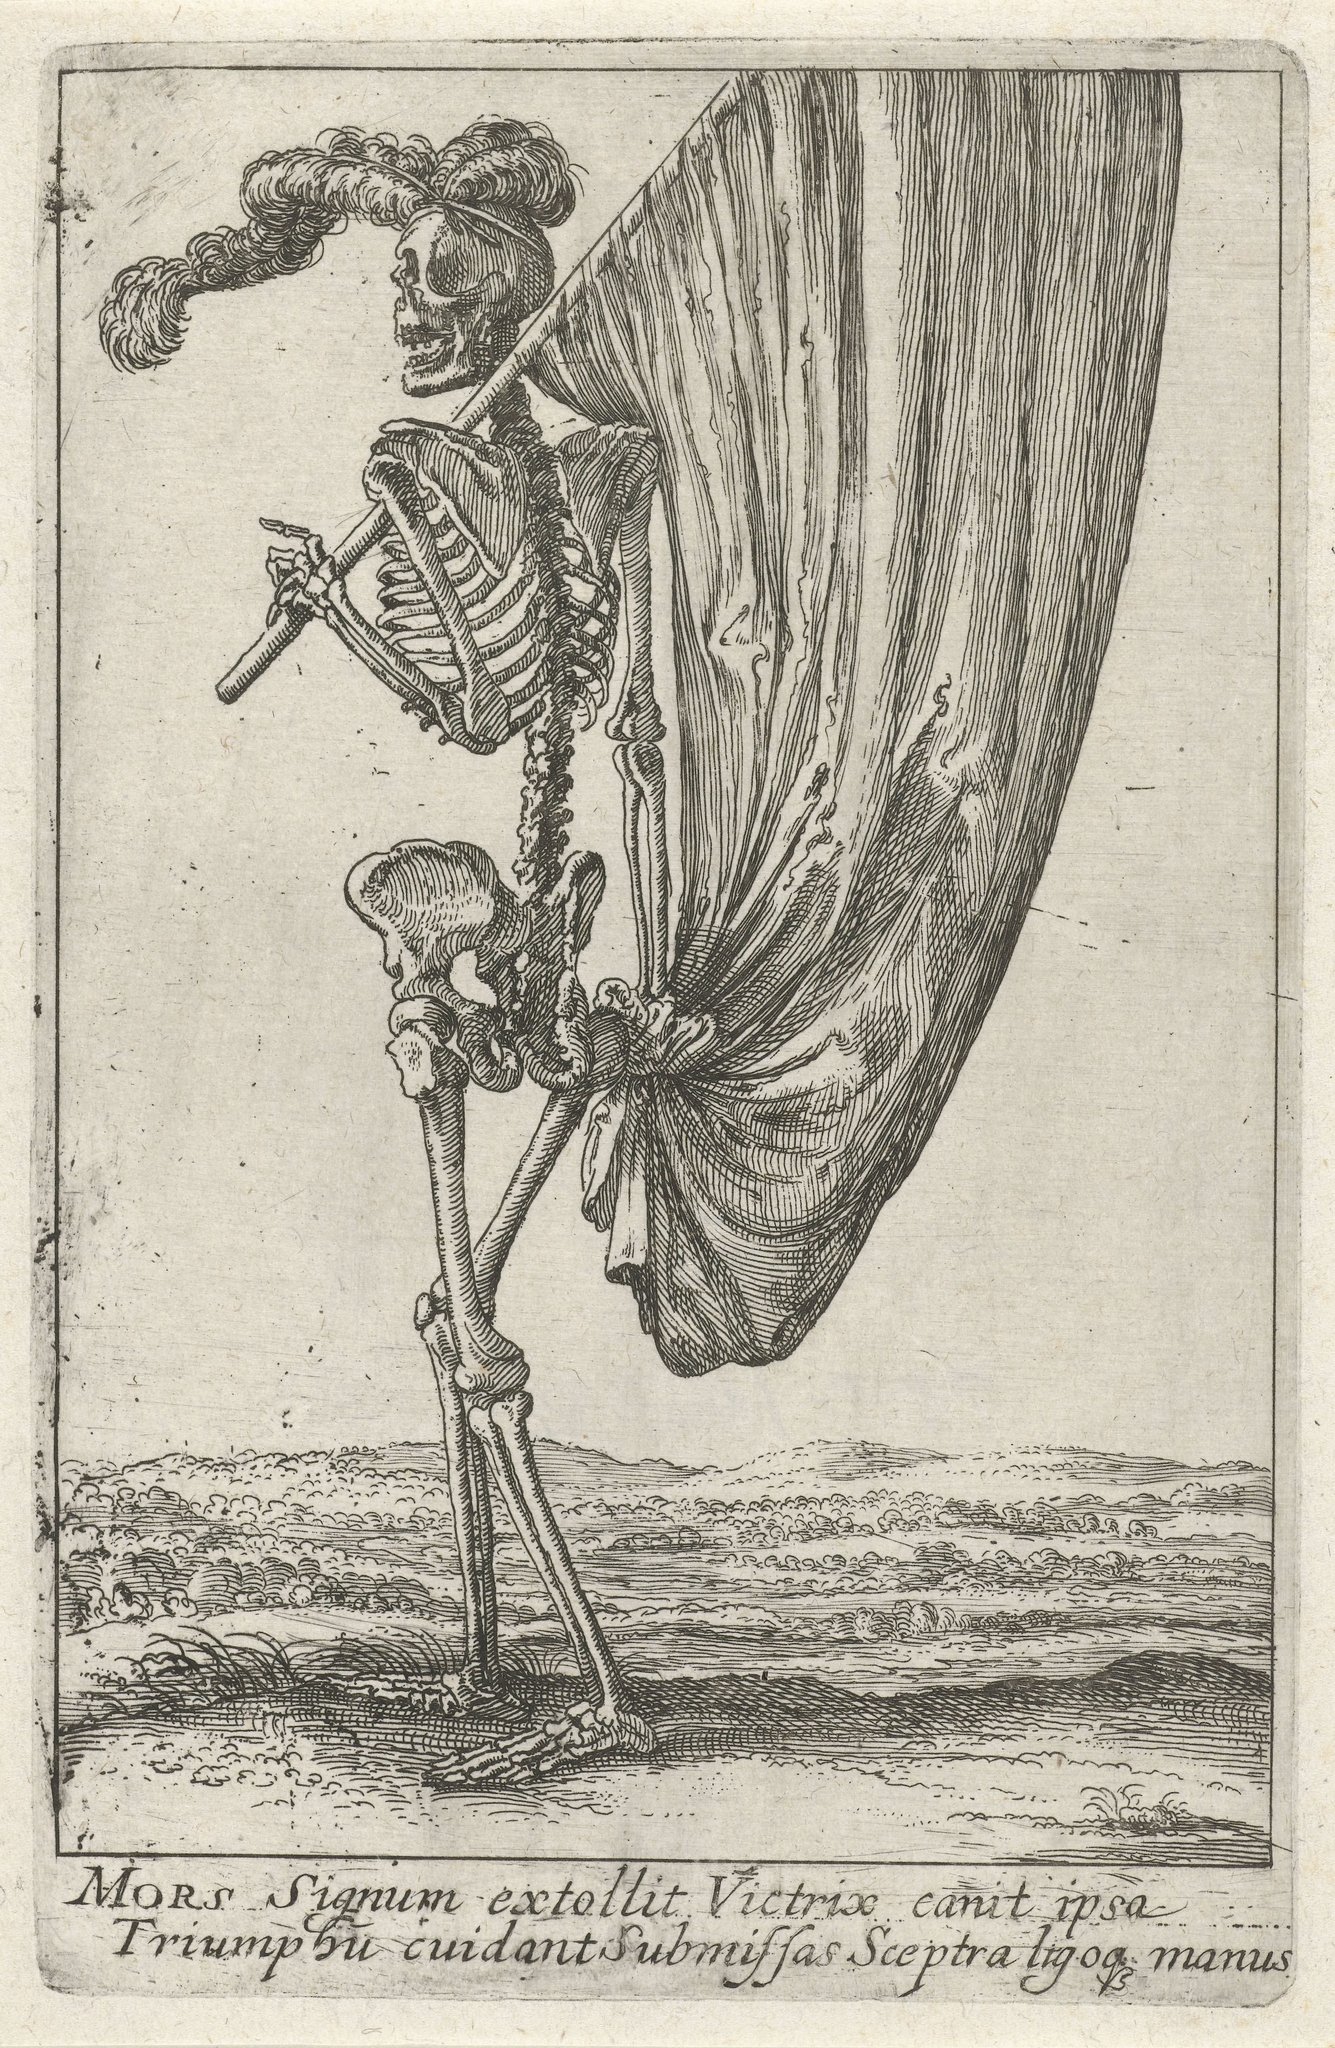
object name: print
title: Skelet met vaandel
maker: hendrick hondius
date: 1625-1652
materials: paper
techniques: etching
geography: the hague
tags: death as skeleton, standard-bearer, flag-bearer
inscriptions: collector's mark: Lugt 2228, inscription: ‘m.o. in kader: MORS Signum extollit Victrix canit ipsa/ Triumphu cuidant submissas sceptra ligos manus.’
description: De Dood in de gedaante van een skelet met een vaandel over zijn schouder, lopend naar links in een landschap. Prent uit een serie van 23 prenten met voorstellingen van skeletten door Hendrick Hondius I, Andries Jacobsz. Stock en Simon Frisius.